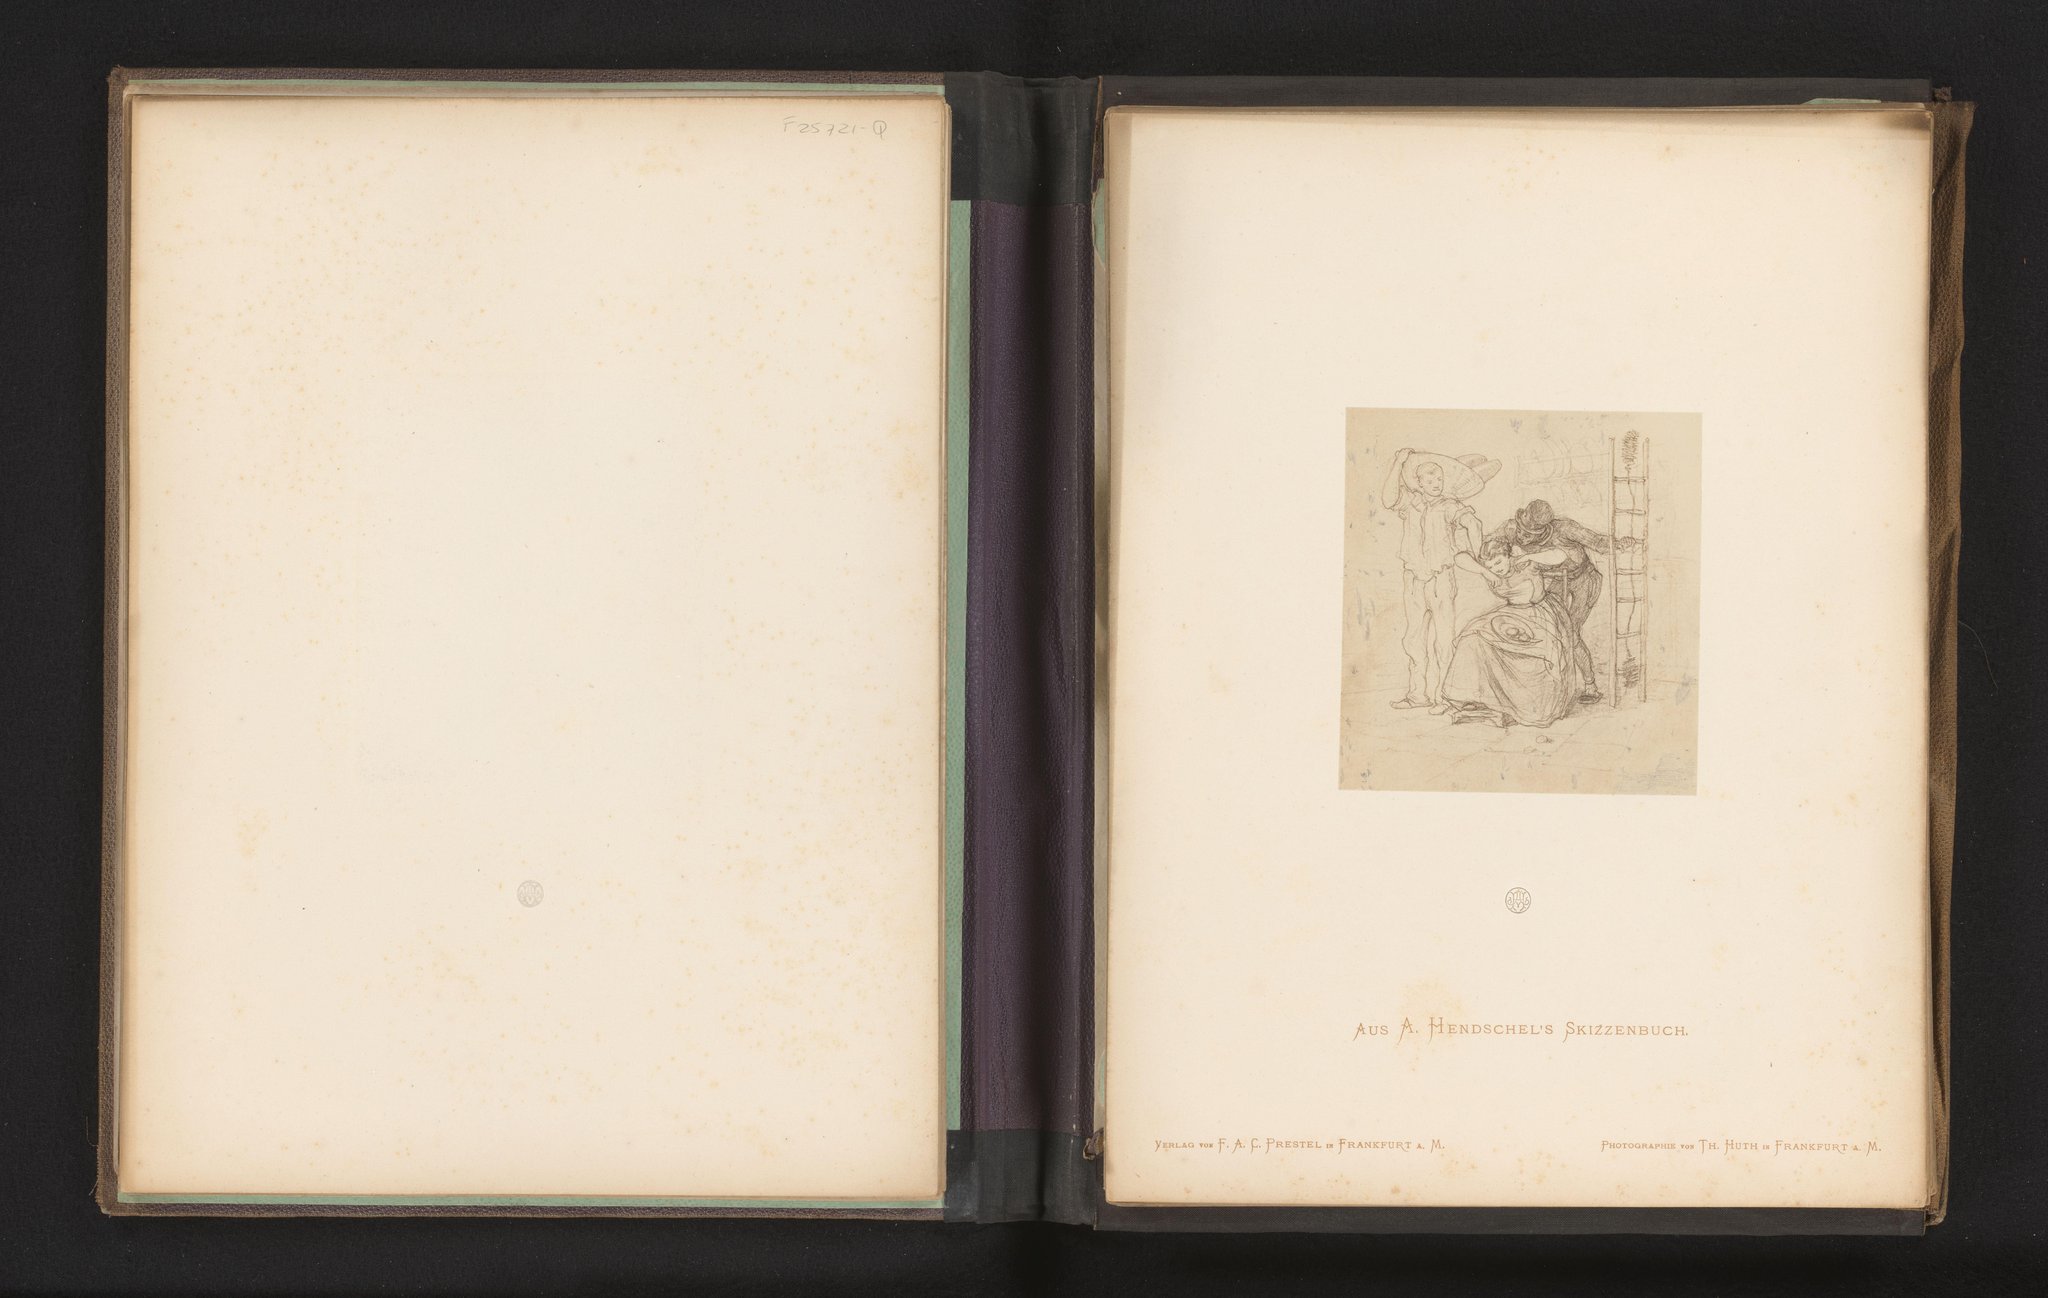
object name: photograph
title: Fotoreproductie van een schets van een bakker, een schoorsteenveger en een vrouw, door Albert Hendschel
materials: paper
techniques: albumen print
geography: frankfurt am main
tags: adult woman, baker, handicrafts ~ maintenance and repair (with name of trade or profession)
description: Deze foto maakt deel uit van een omslag met 50 foto's op 48 bladen, een lijst van afbeeldingen en een titelblad.